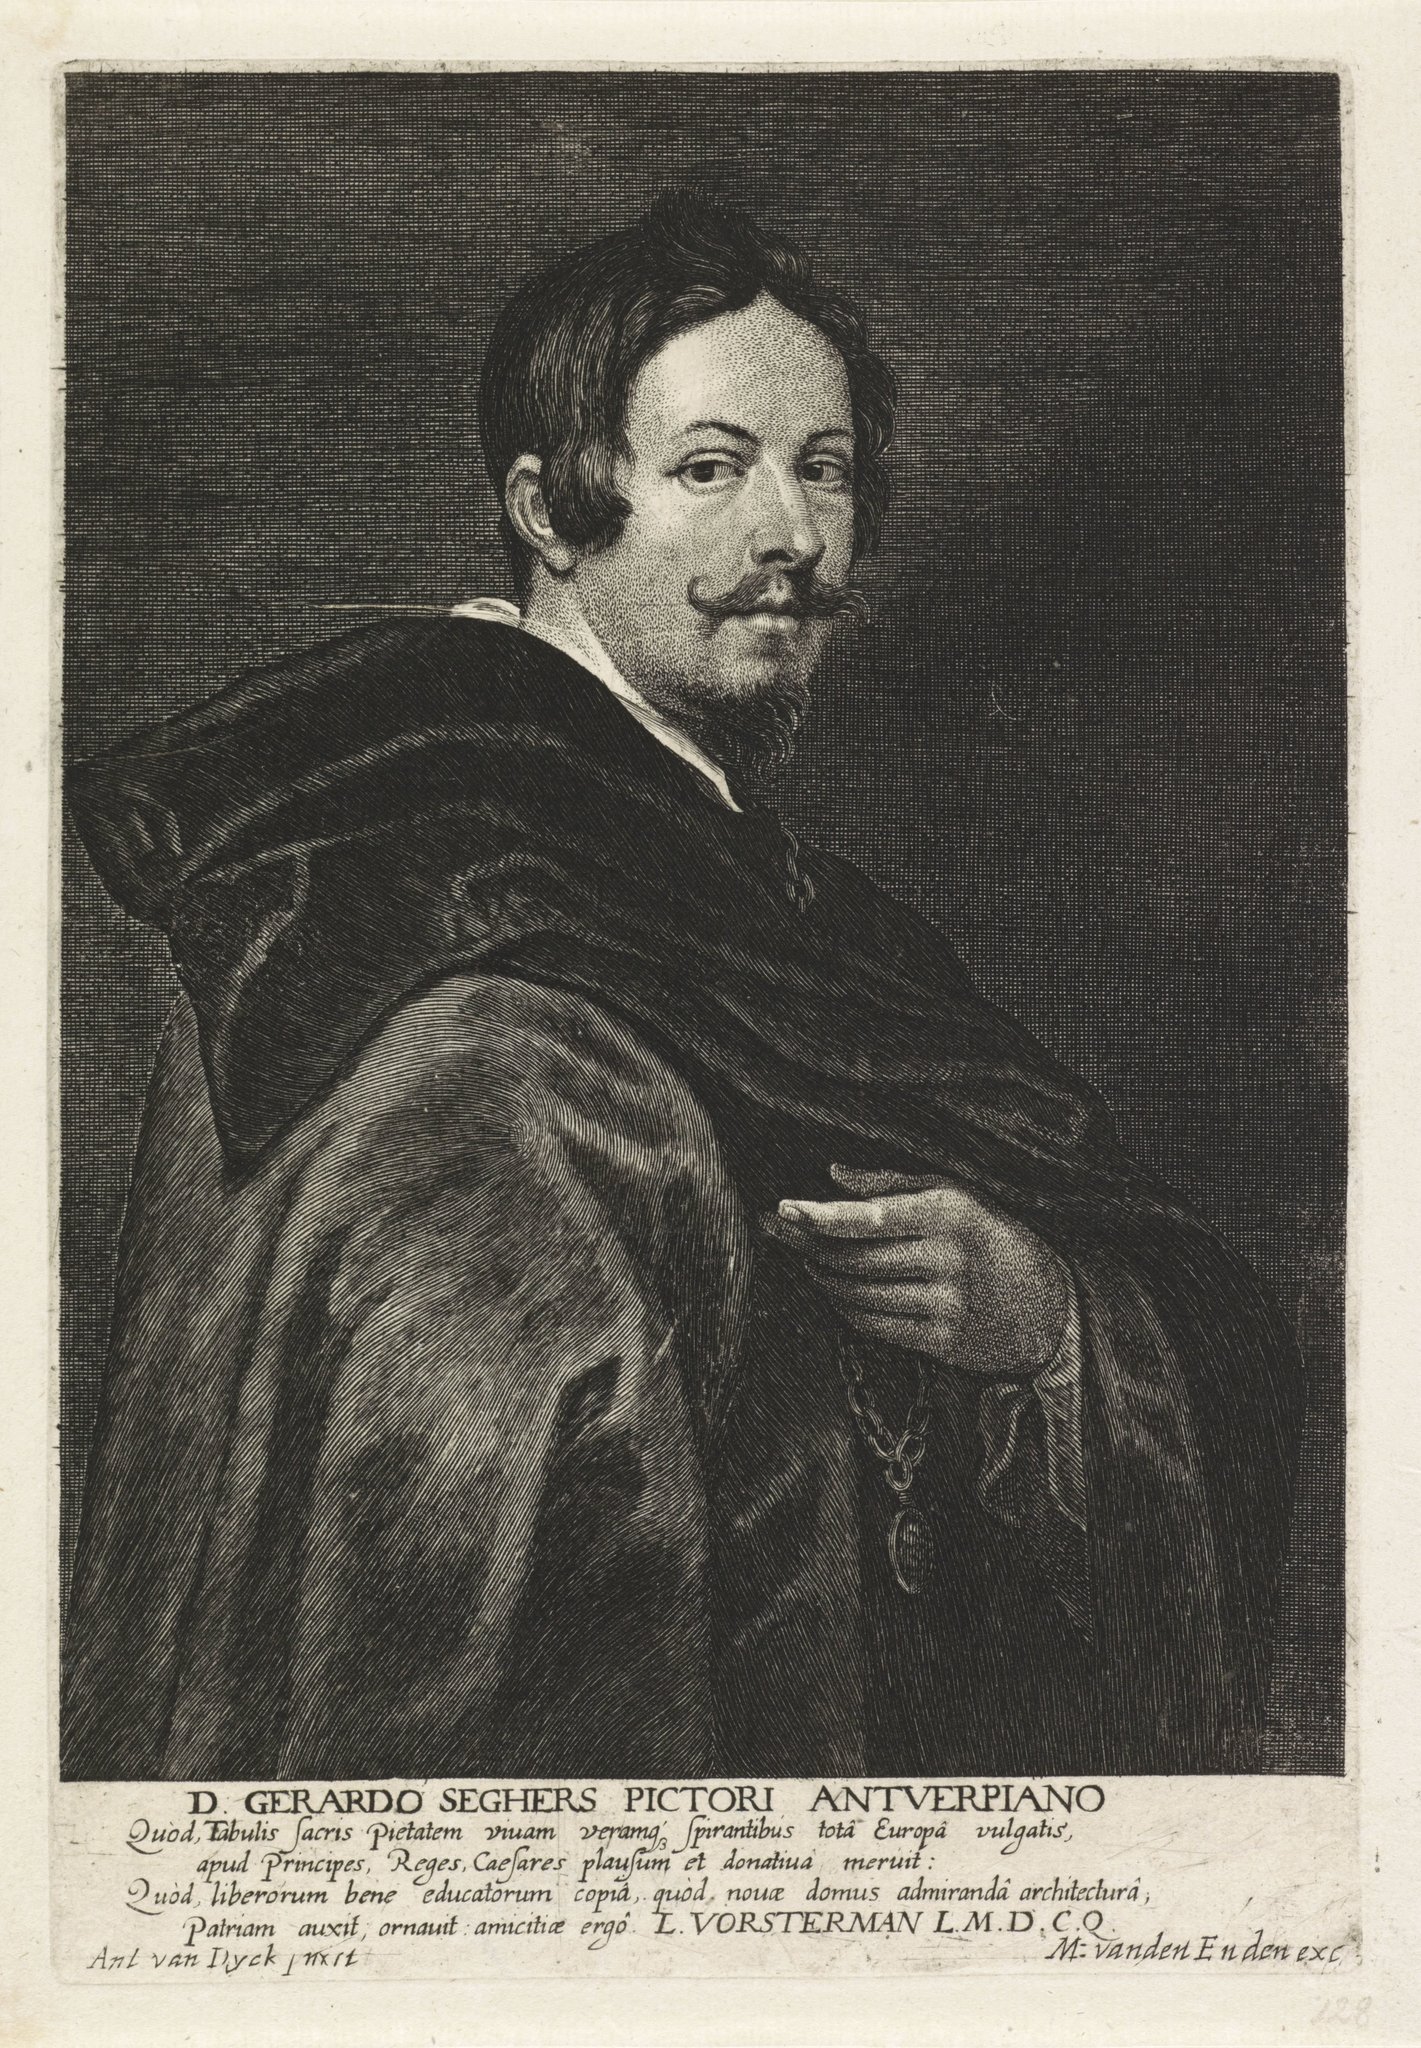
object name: print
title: Portret van Gerard Seghers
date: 1630-1674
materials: paper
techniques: engraving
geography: antwerp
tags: antwerp, gerard seghers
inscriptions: collector's mark: Lugt 240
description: Portret van de Antwerpse prentmaker en schilder Gerard Seghers.